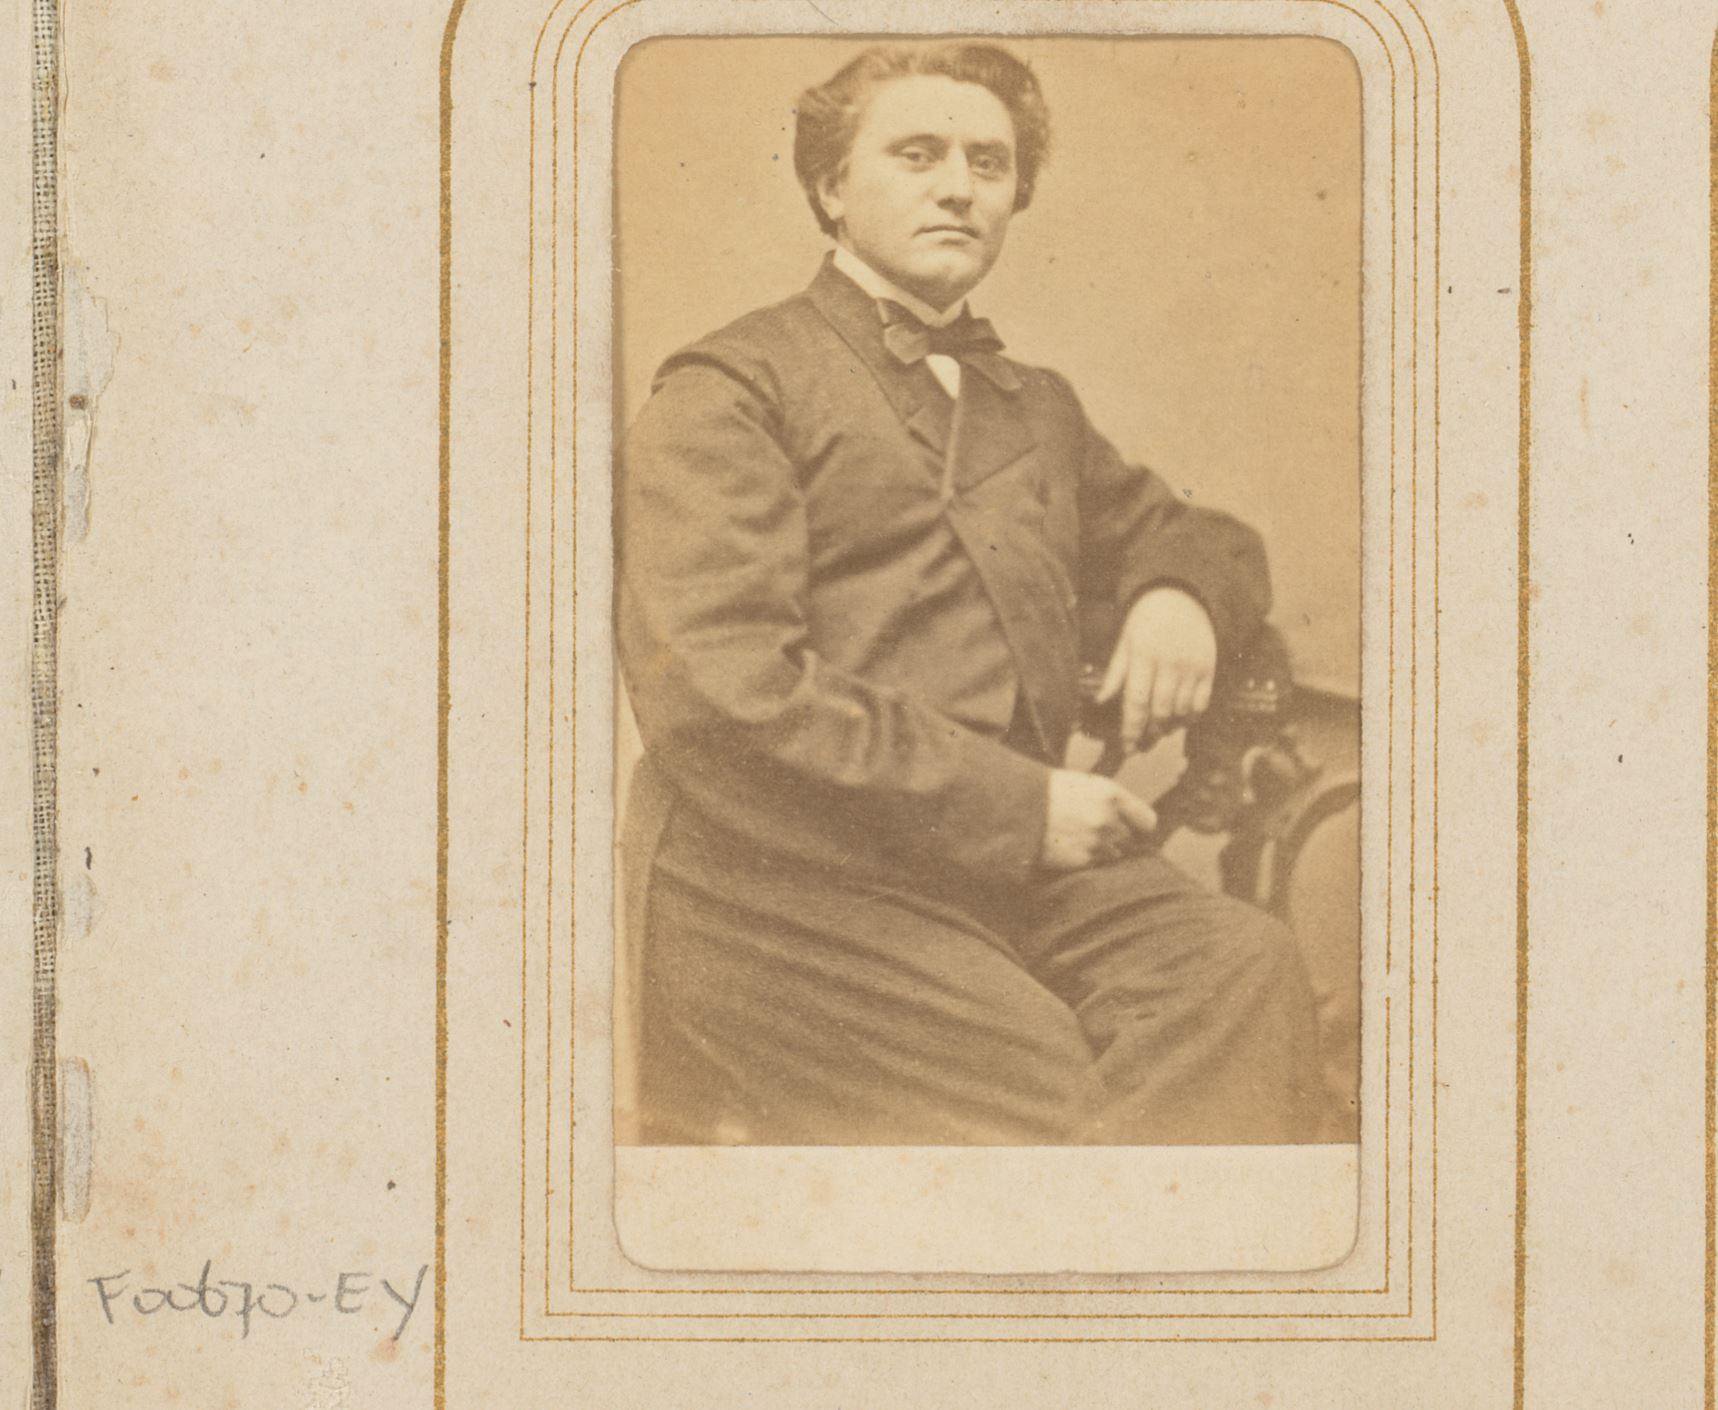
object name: album leaf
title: Portret van Frederik Karel Antonius Pantekoek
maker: s. carspel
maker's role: fotograaf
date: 1850-1878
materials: cardboard, photographic support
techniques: albumen print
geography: amsterdam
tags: nijmegen, amsterdam, historical persons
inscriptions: annotation: ‘Ds. Pantekoek/ Pantekoek’, annotation: ‘ds. Pantekoek (foto S. Carspel, A'dam)’, inscription: ‘Photographie/ S. Carspel/ Bloemgracht D.43/ Amsterdam’